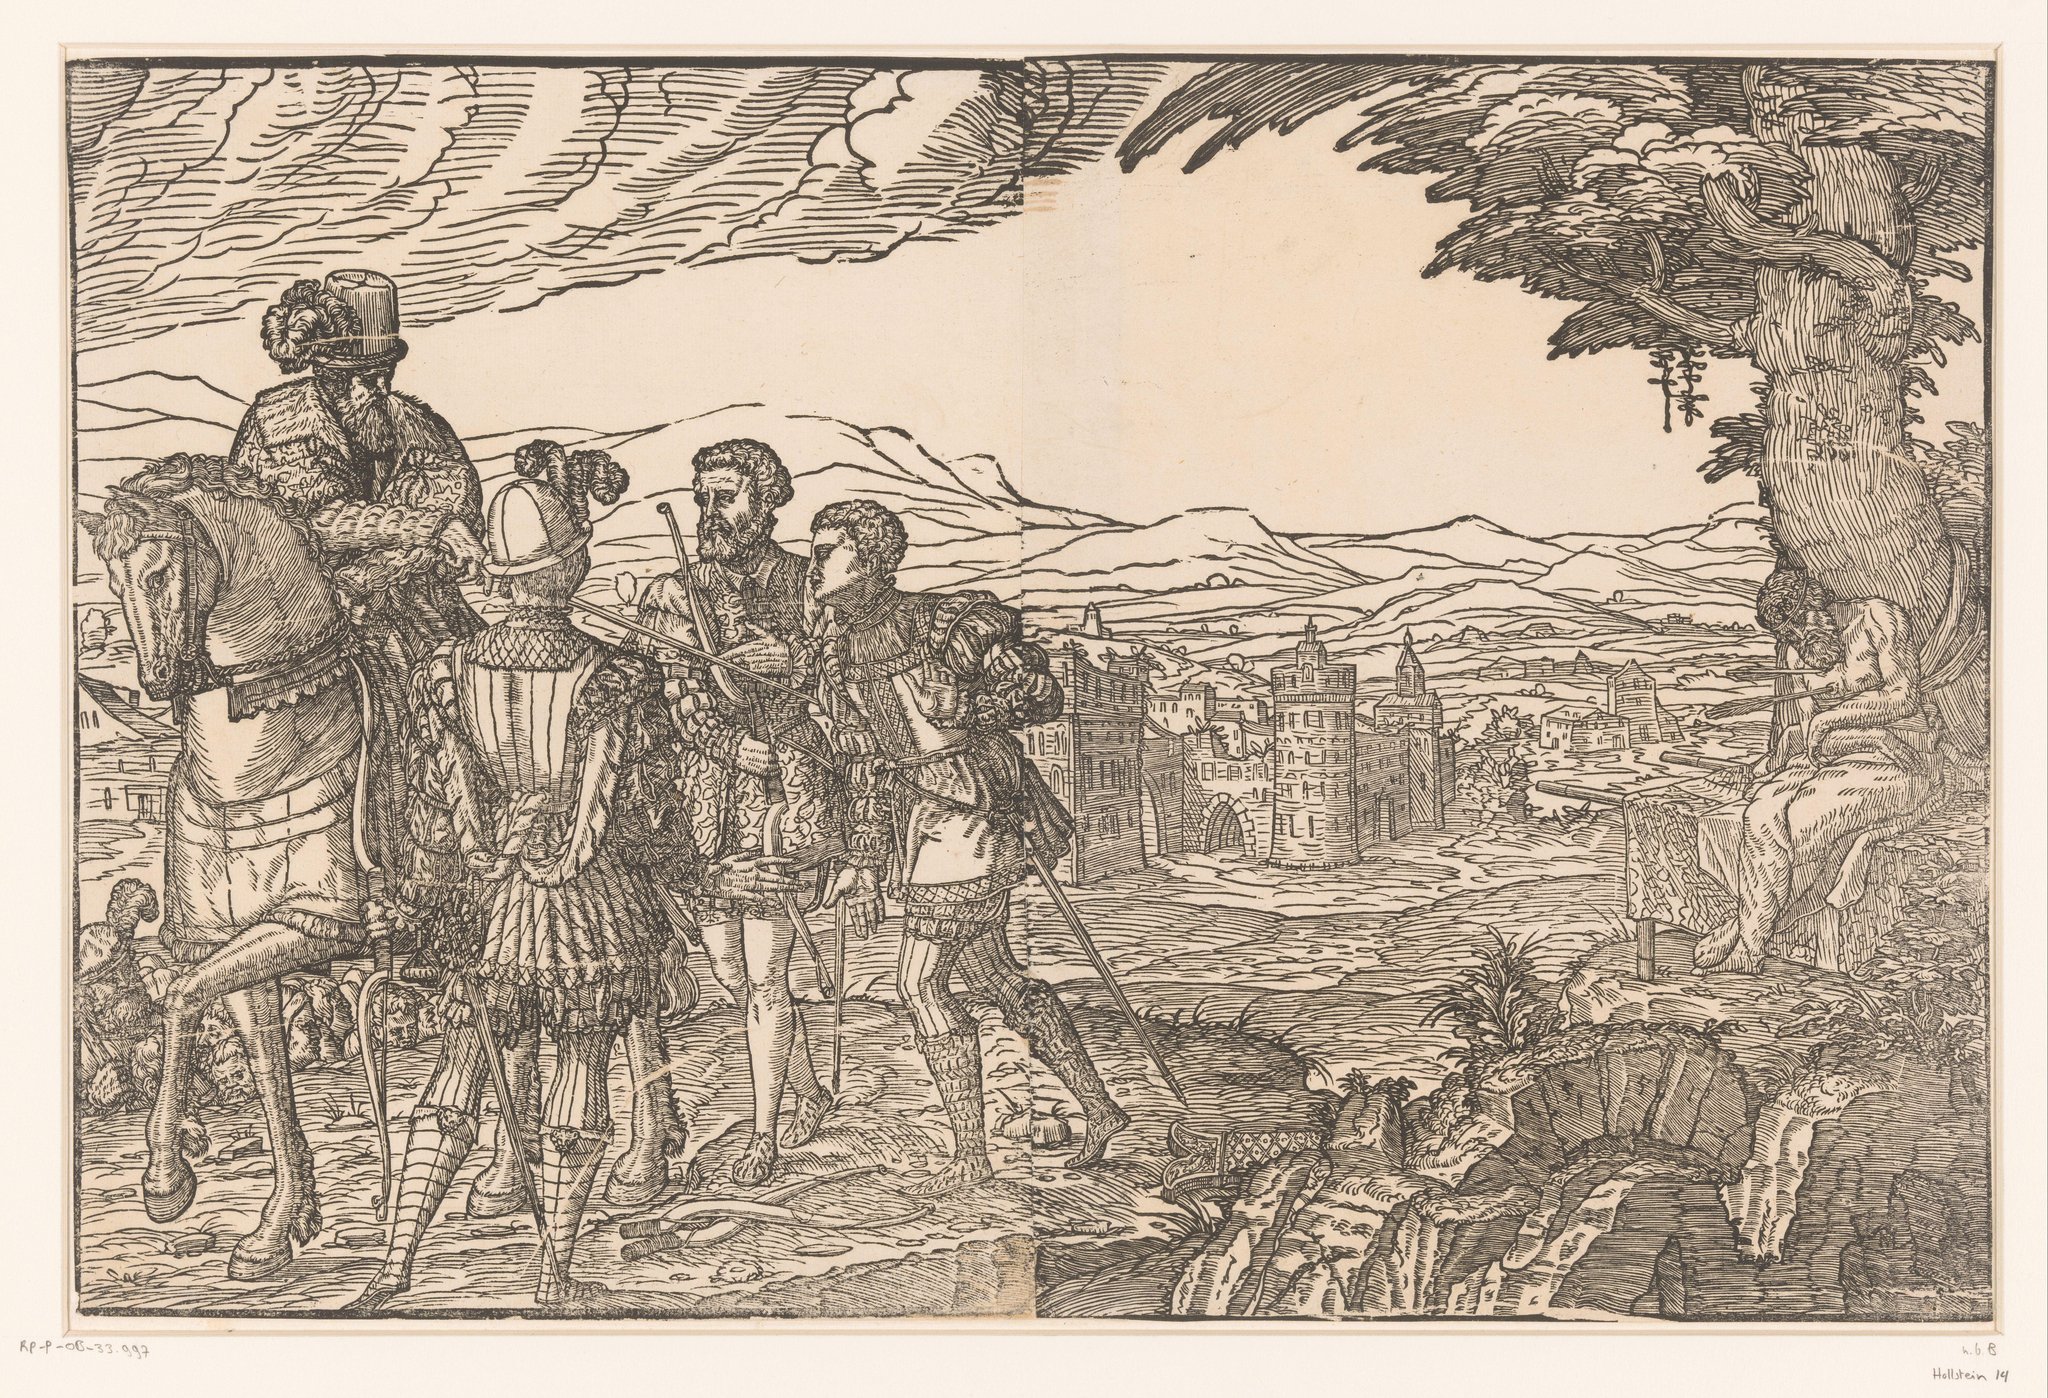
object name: print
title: De zoon weigert op het lijk van zijn vader te schieten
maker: melchior lorck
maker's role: draughtsman, painter, print maker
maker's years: 1526-1588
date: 1551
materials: paper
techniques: woodcut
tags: (gesta romanorum) specific works of literature (with author, title), shooting at father's corpse: two rival heirs are forced by a judge to shoot an arrow at a corpse; the false heir does not hesitate to do so, the true one, knowing that he will be shooting at his father, refuses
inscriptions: collector's mark: Lugt 240